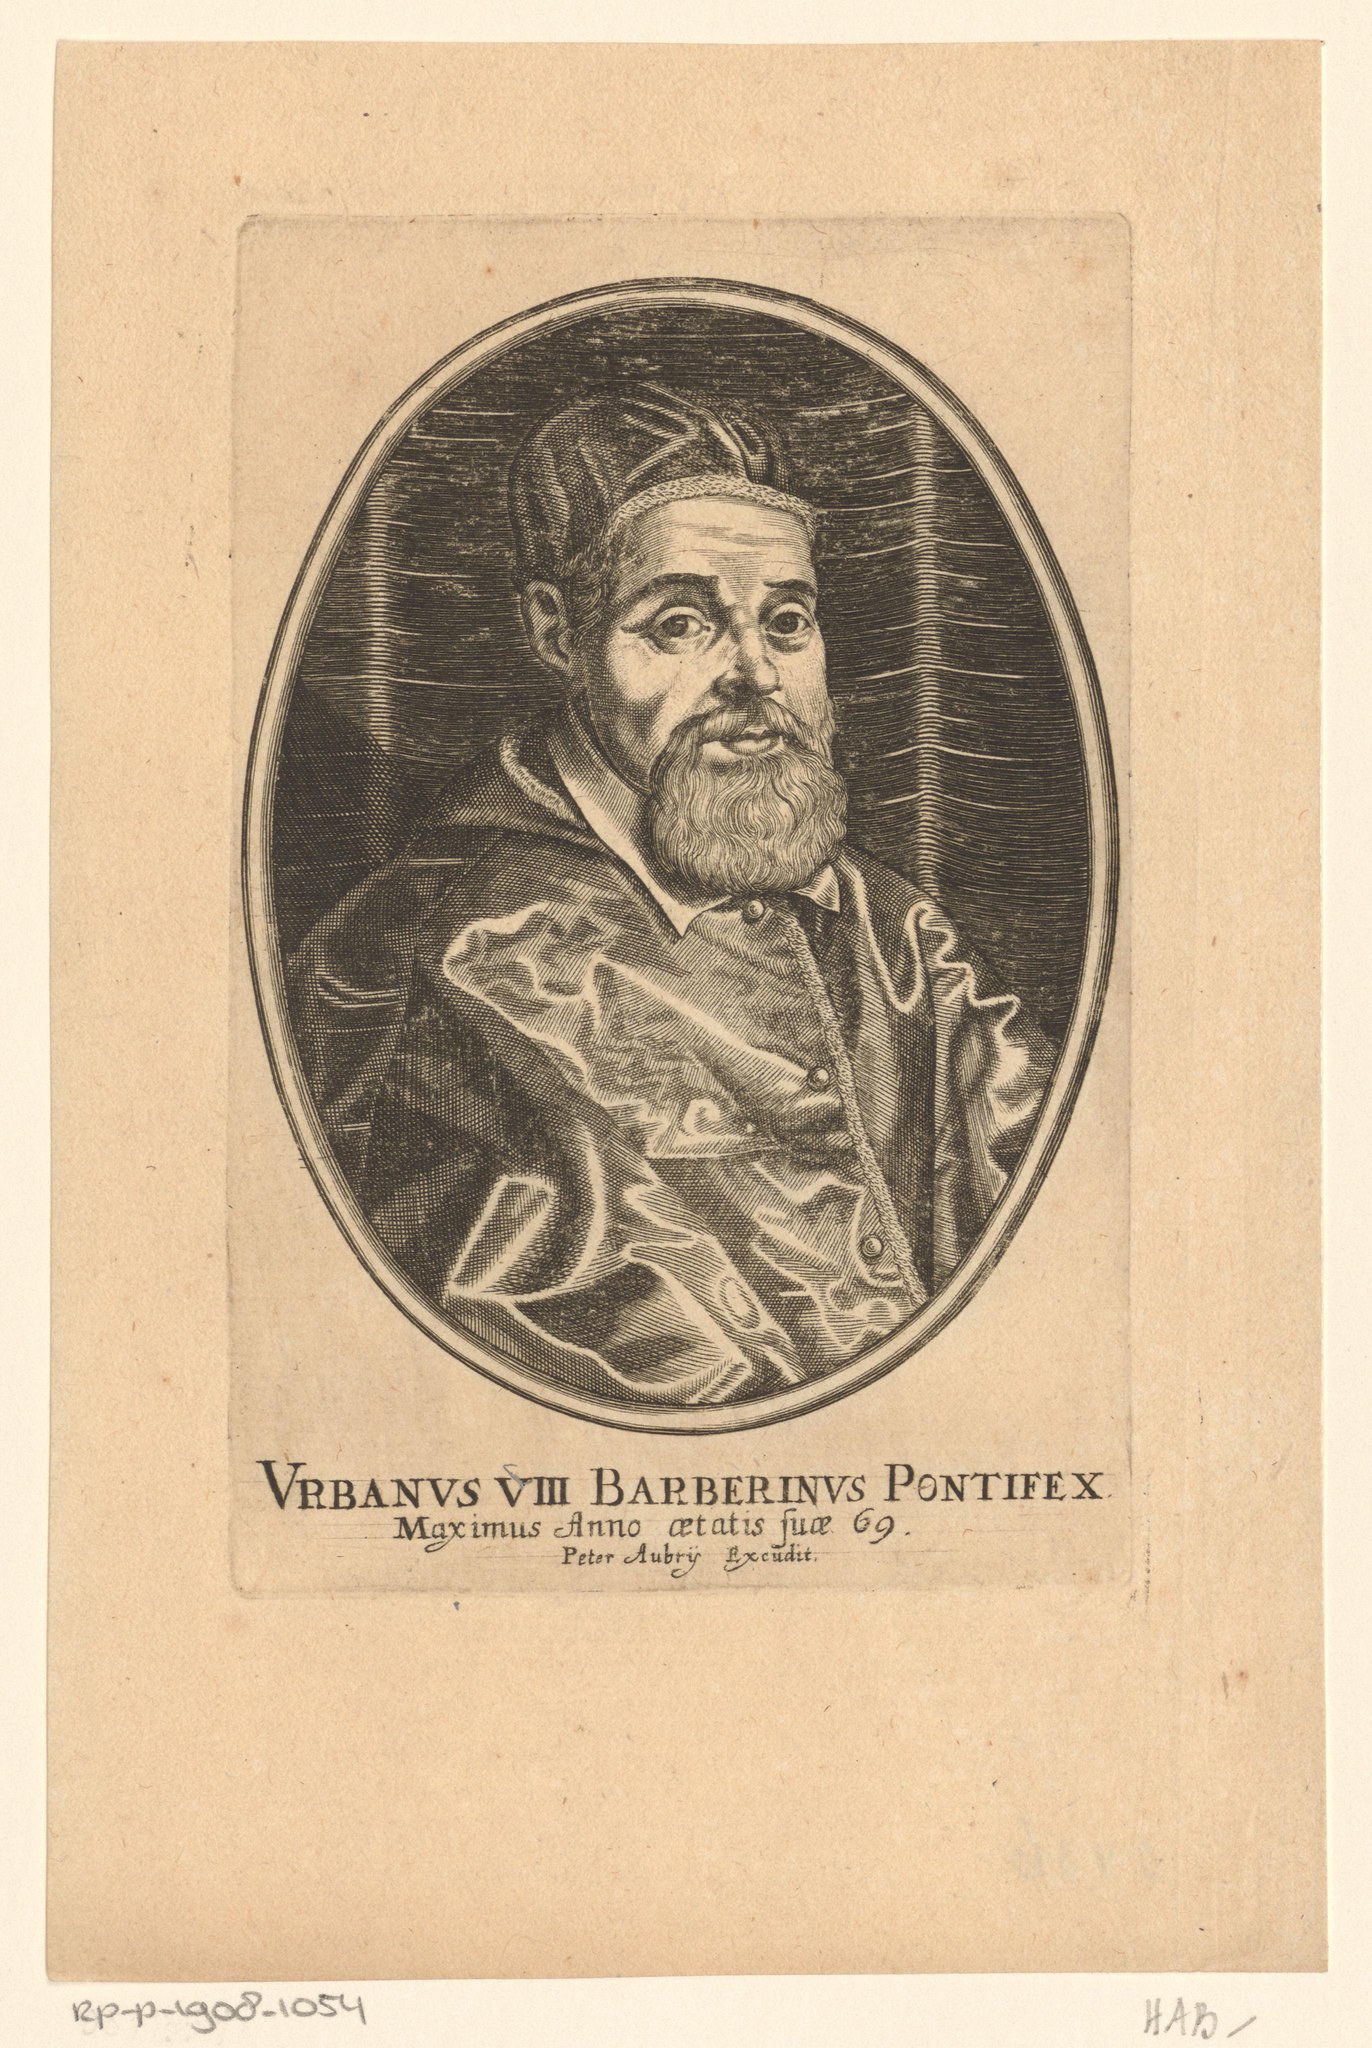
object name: print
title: Portret van paus Urbanus VIII op 69-jarige leeftijd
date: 1637-1666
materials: paper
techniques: engraving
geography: straatsburg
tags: clergyman, urbanus viii, historical persons, pope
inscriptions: collector's mark: Lugt 2228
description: Prent mogelijk uit een editie van Theatrum Europeaum.